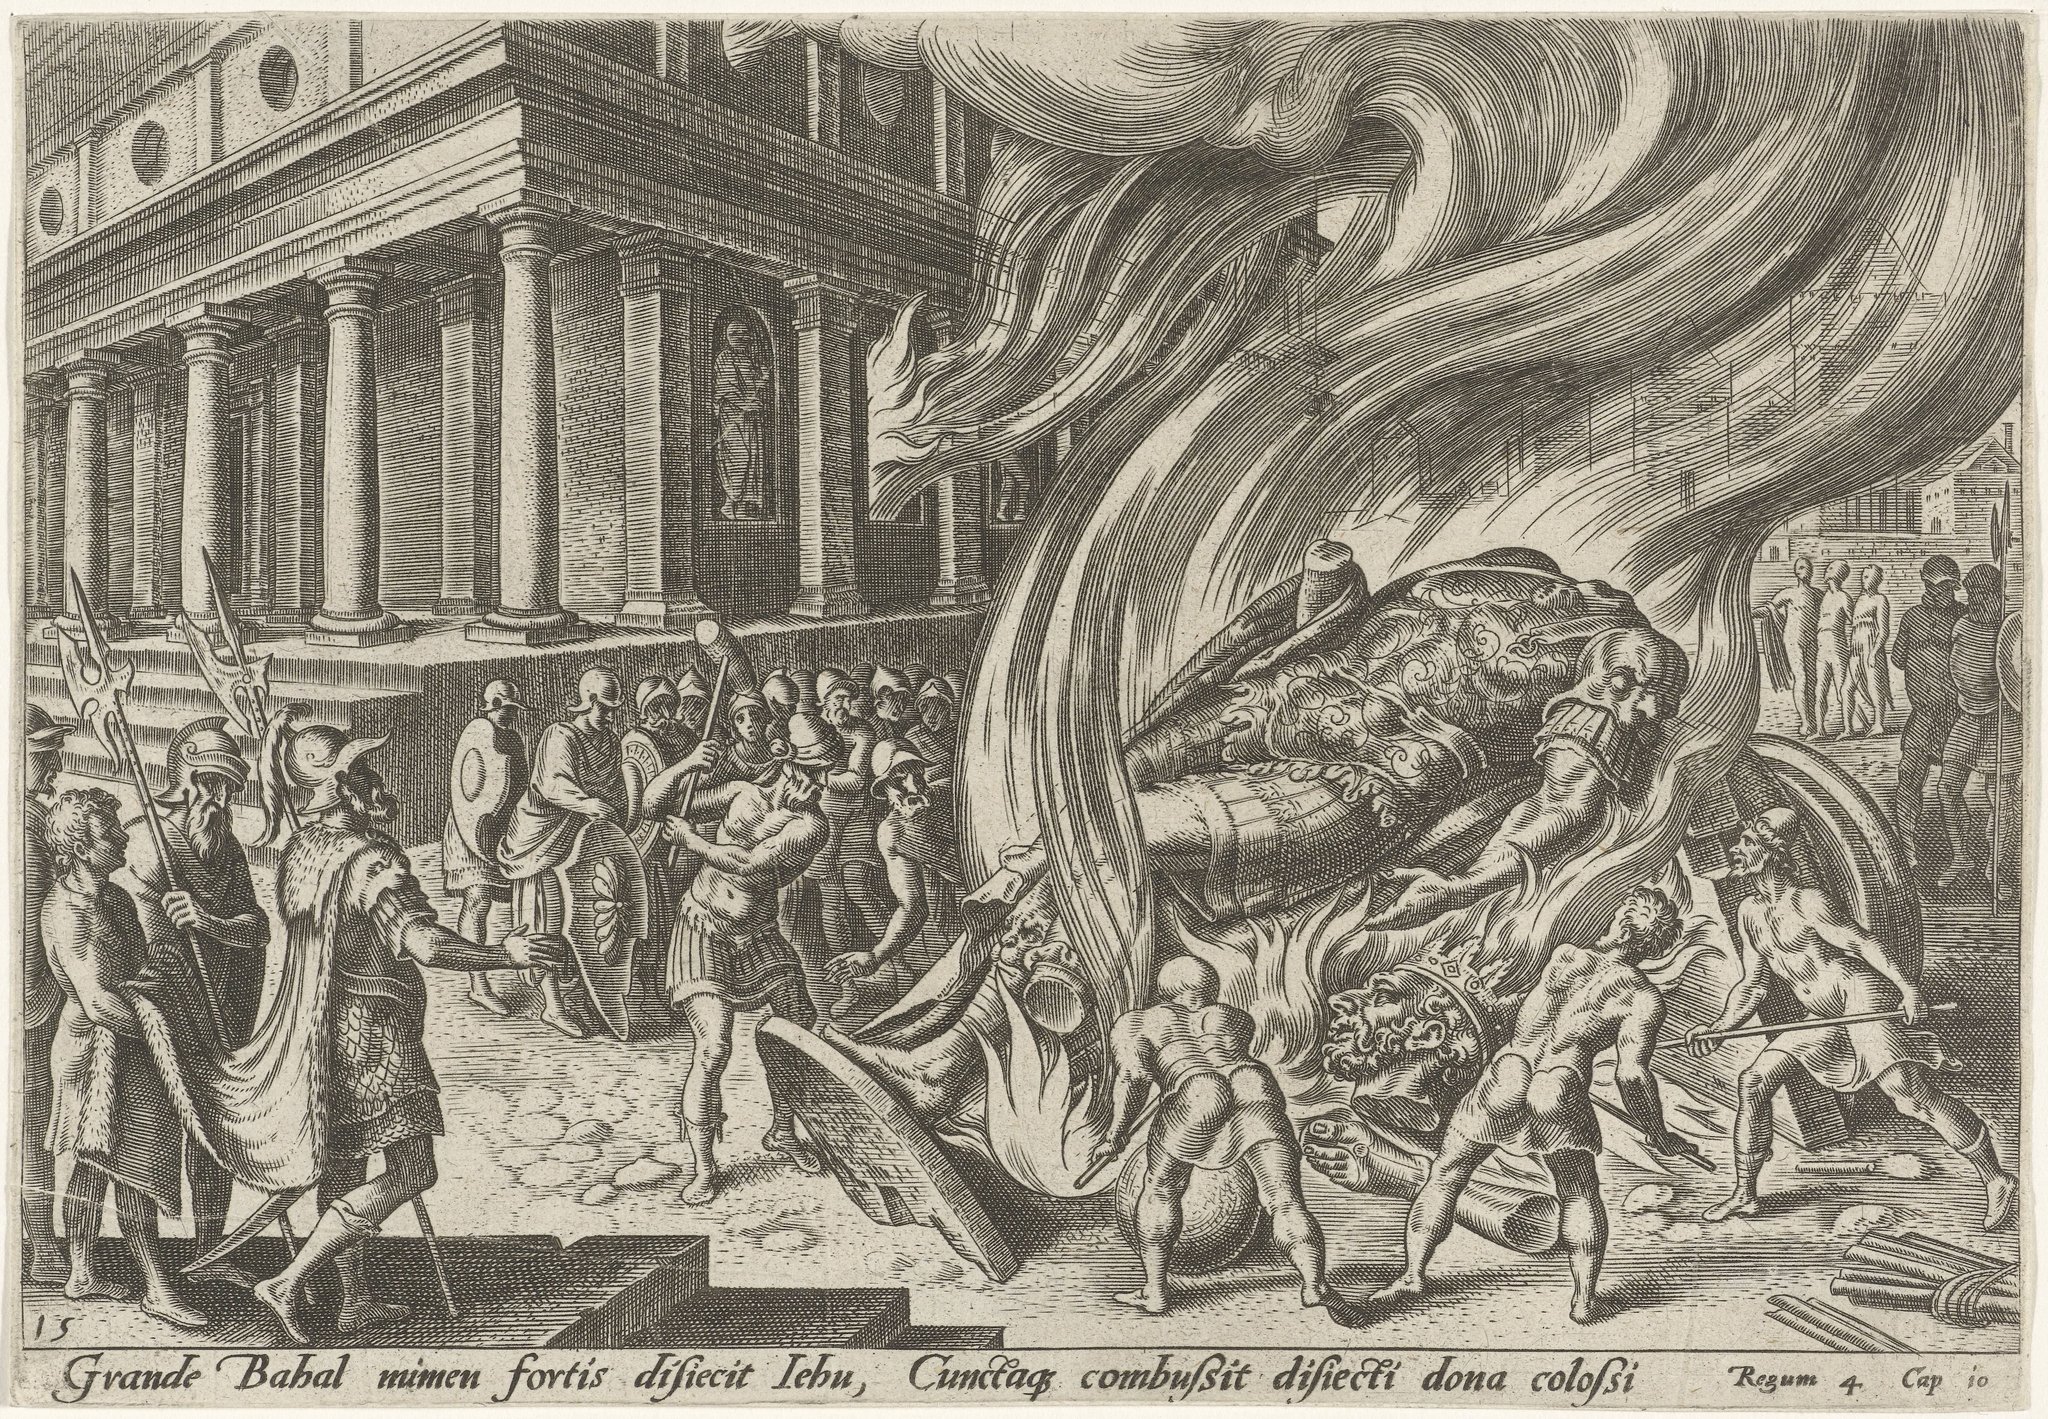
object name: print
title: Jehu verwoest de tempel en het beeld van Baal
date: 1569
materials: paper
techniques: engraving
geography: haarlem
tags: the worshippers of baal are killed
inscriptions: number: ‘15’, caption: ‘Grande Bahal numen fortis disiecit Iehu...Regum 4 Cap. 10’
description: Op de voorgrond wordt het grote afgodsbeeld van Baal in brand gestoken en met hamers verwoest. Op de achtergrond de tempel die eveneens brandt.